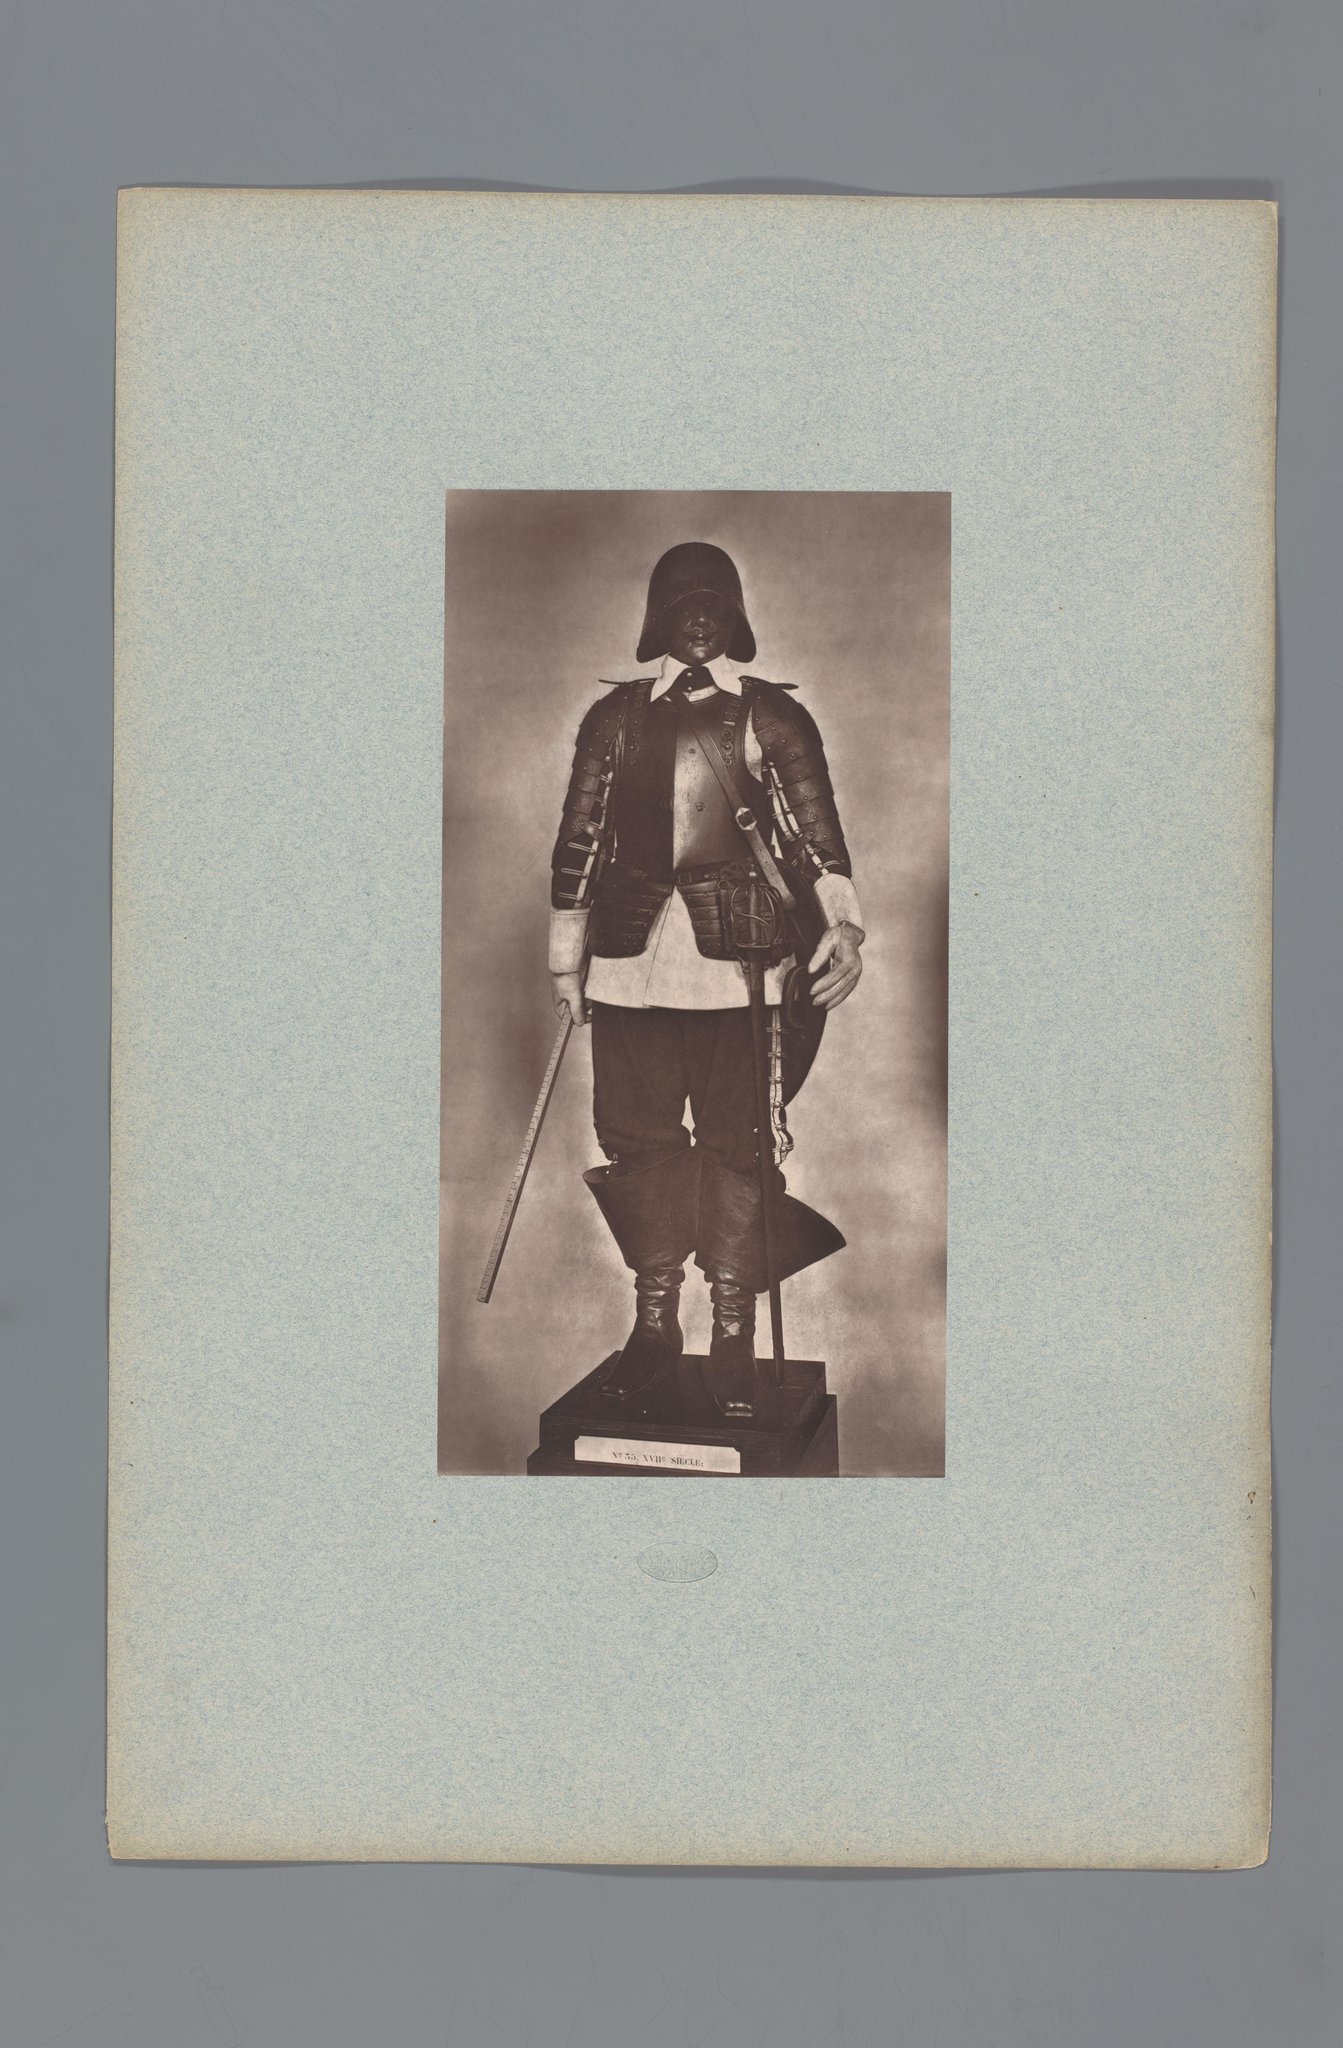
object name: photomechanical print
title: 17de-eeuws harnas met zwaard uit het leger van Lodewijk XIII van Frankrijk, uit de collectie van het Musée d'Artillerie in Parijs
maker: Anonymous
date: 1877-1882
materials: paper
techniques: woodburytype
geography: paris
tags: armour, hacking and thrusting weapons: sword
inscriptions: check stamp: ‘PHOTOGLYPTIE/ LEMERCIER ET Cie/ PARIS’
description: Deze prent maakt deel uit van een omslag met 36 prenten, een titelblad en een lijst van afbeeldingen.